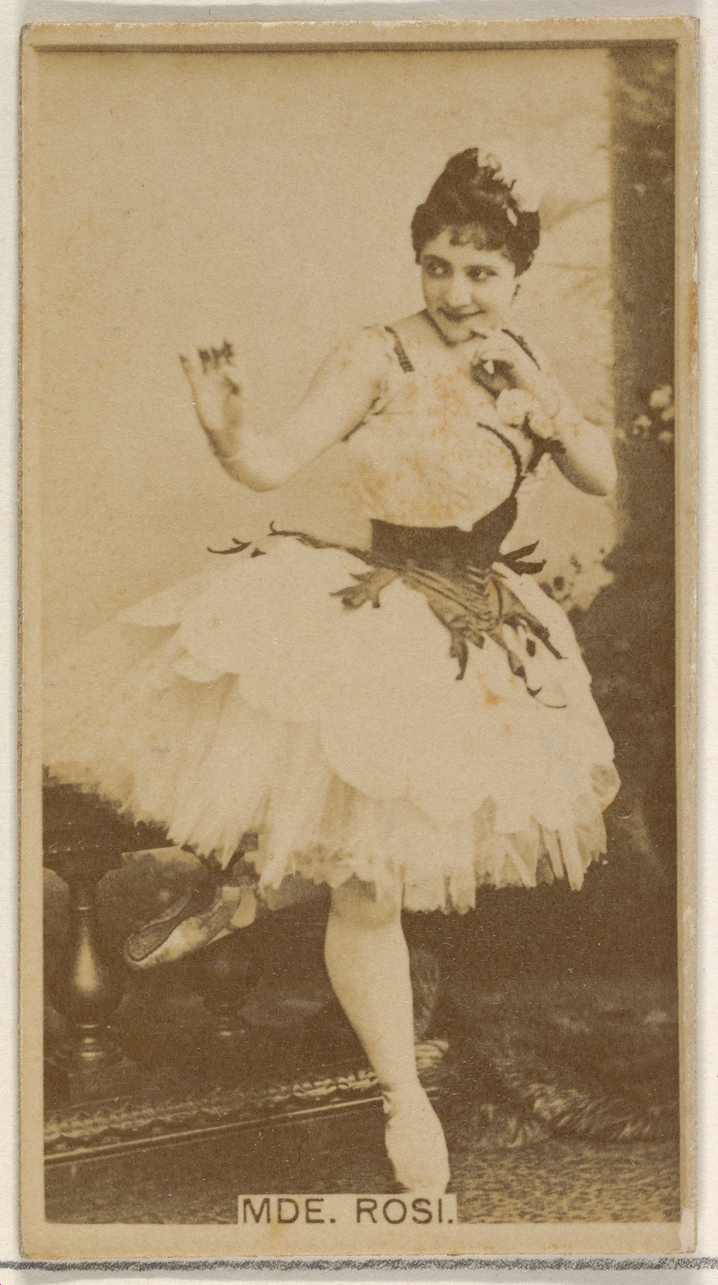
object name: photograph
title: Mde. Rosi, from the Actors and Actresses series (N45, Type 8) for Virginia Brights Cigarettes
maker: allen & ginter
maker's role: publisher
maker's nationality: american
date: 1888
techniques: albumen silver print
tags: portraits,women,actresses